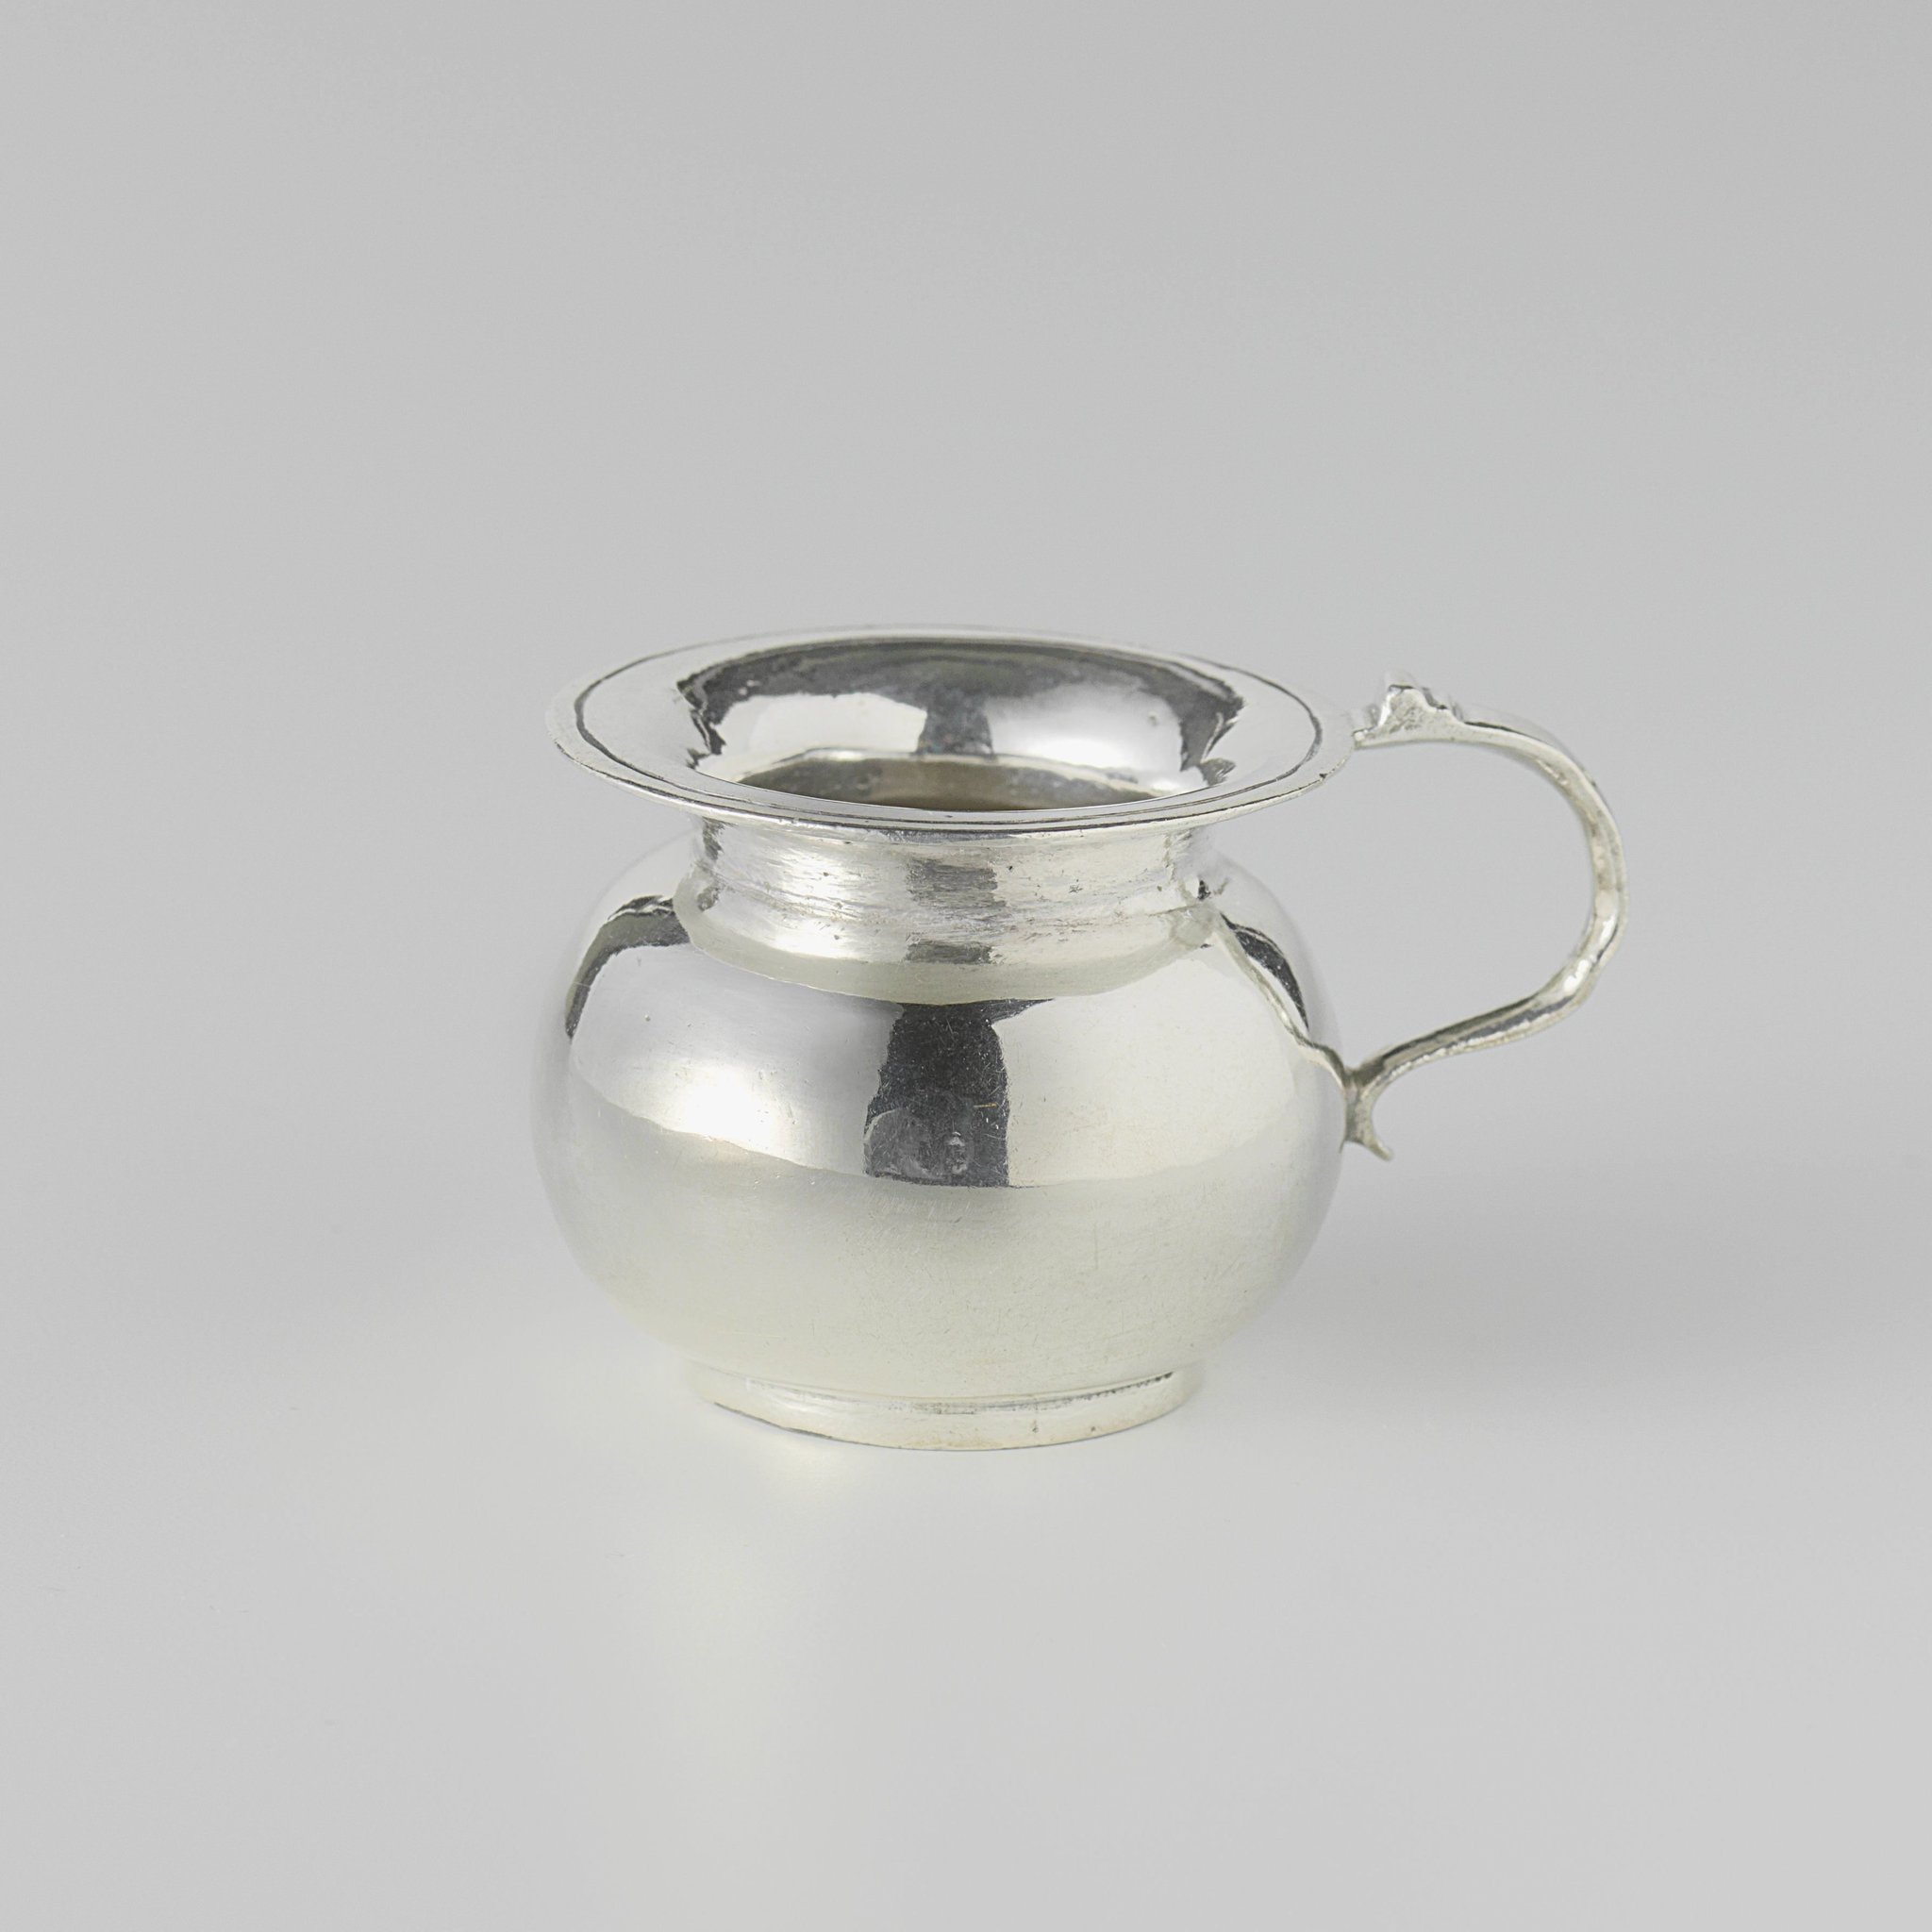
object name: miniature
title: Waterpot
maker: frederik van strant (i)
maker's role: silversmith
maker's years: 1678-1727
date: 1725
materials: silver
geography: amsterdam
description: Waterpot, rond, met een voluutvormig handvat. De pot heeft een brede, platte rand, waarlangs een lijn is gegraveerd. De pot is gemerkt: stk.= Amsterdam, mt.= Frederik van Strant I, gekroonde O, de letter V, een herkeur (1812-1813) en een zwijnskop.